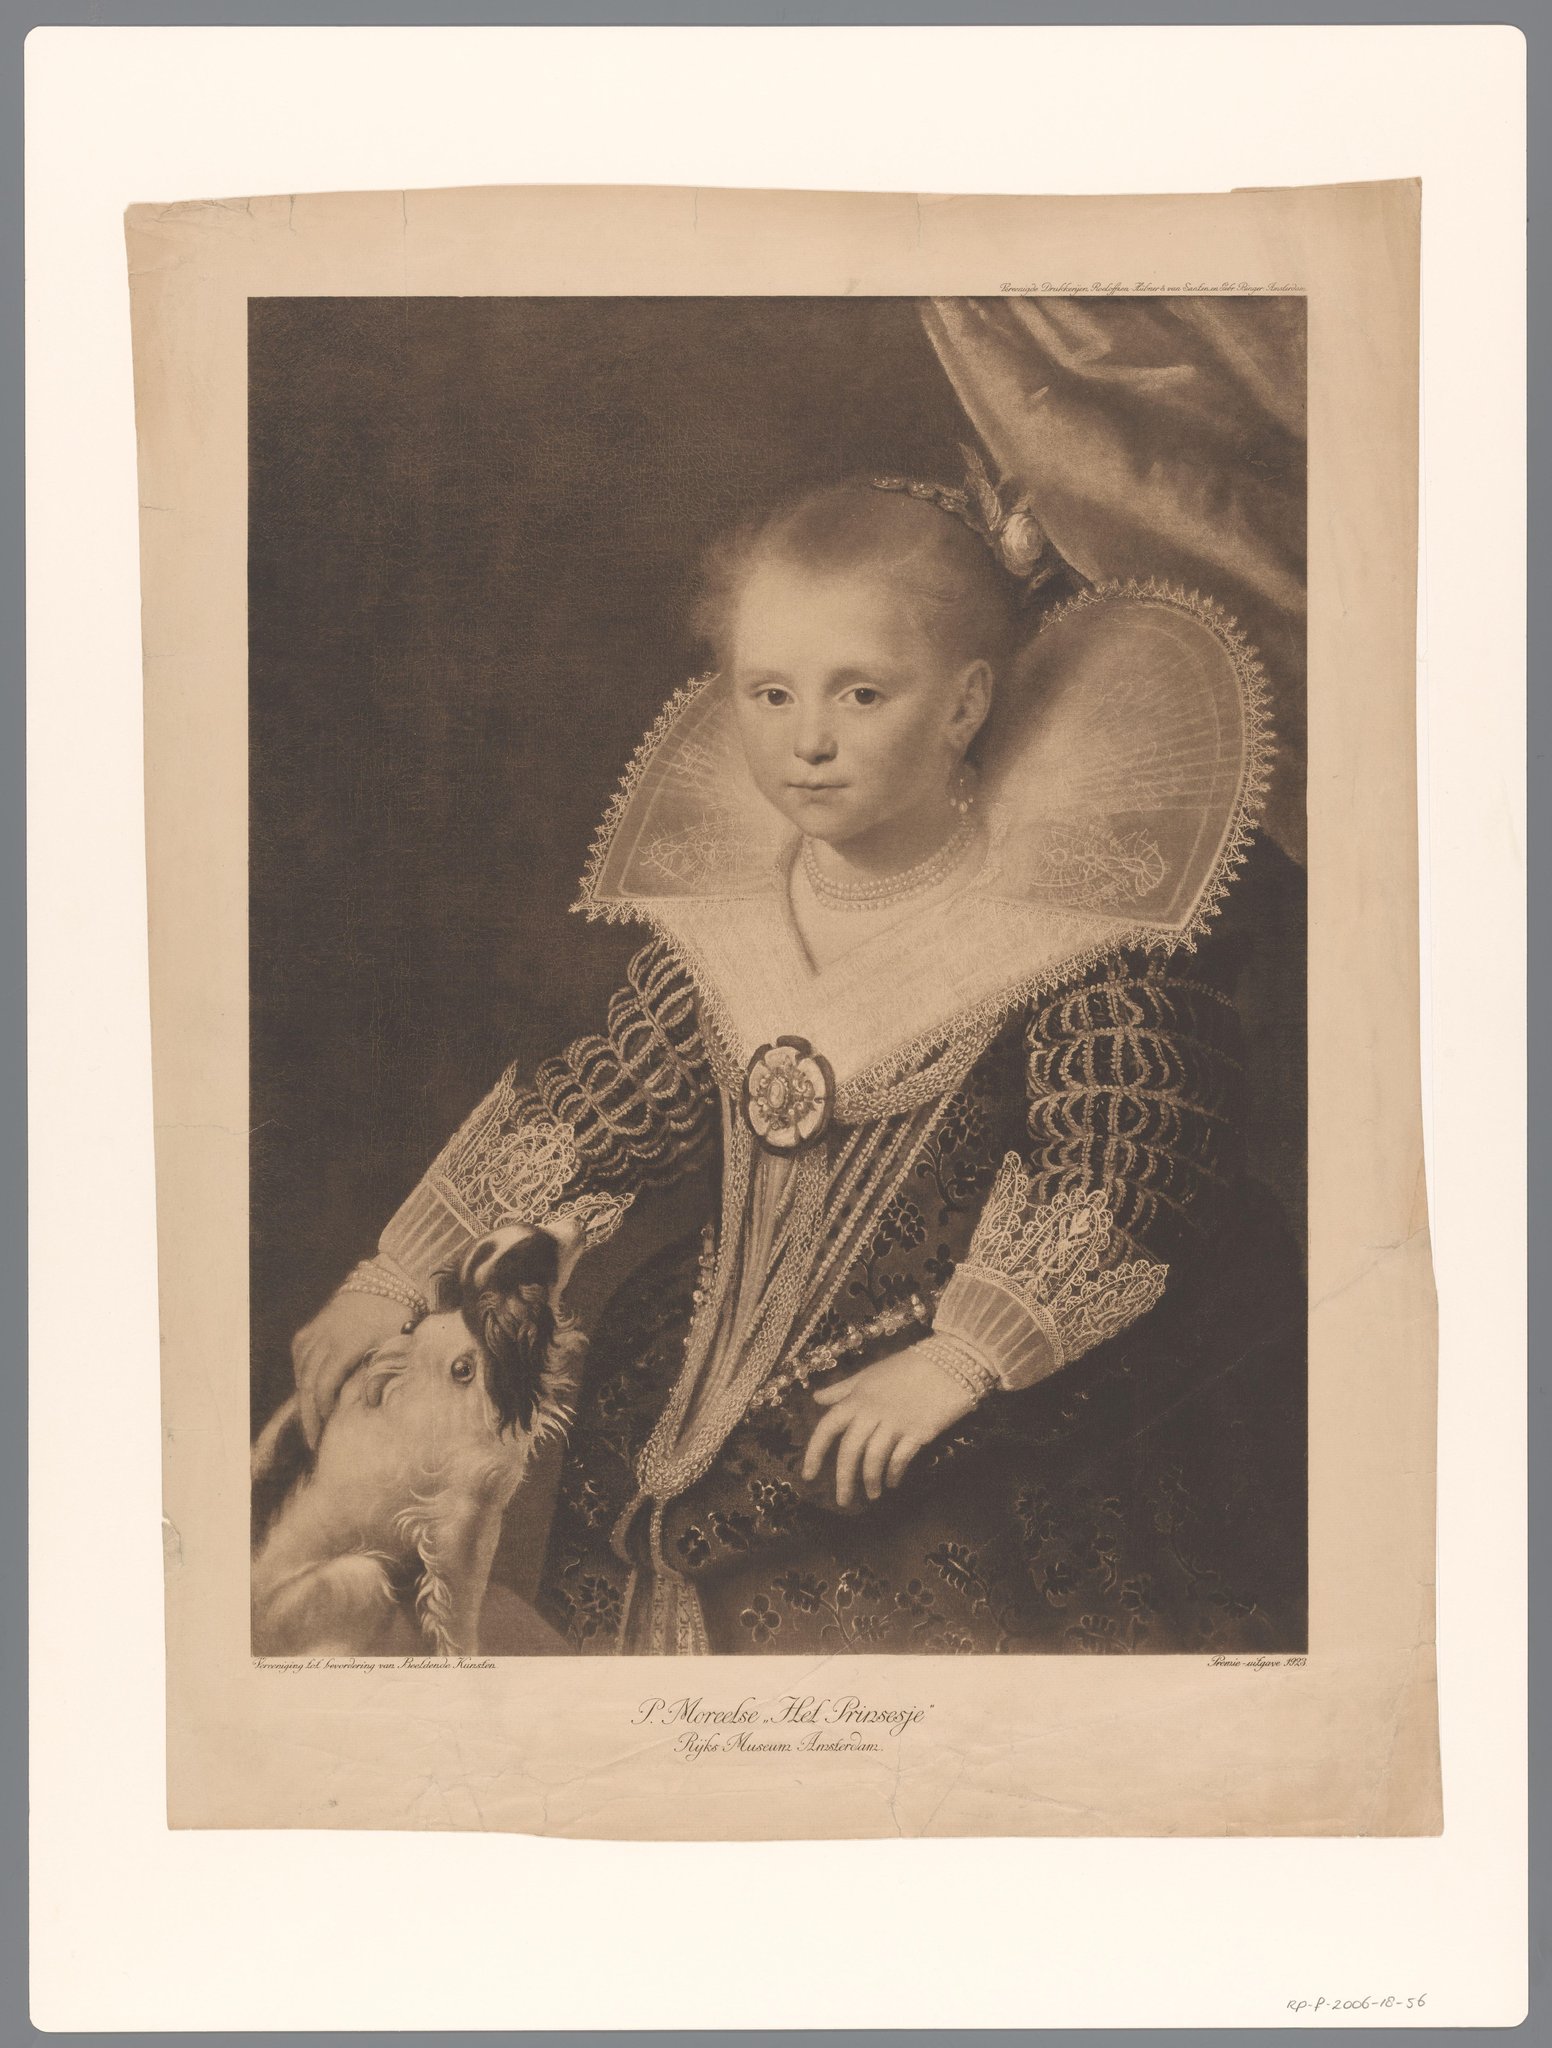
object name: print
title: Het prinsesje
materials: paper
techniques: lithograph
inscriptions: : ‘Vereeniging tot Bevordering van Beeldende Kunsten Premie-uitgave 1923. / P. Moreelse "Het Prinsesje" / Rijks-Museum Amsterdam.’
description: Reproductie van een schilderij van P. Moreelse.